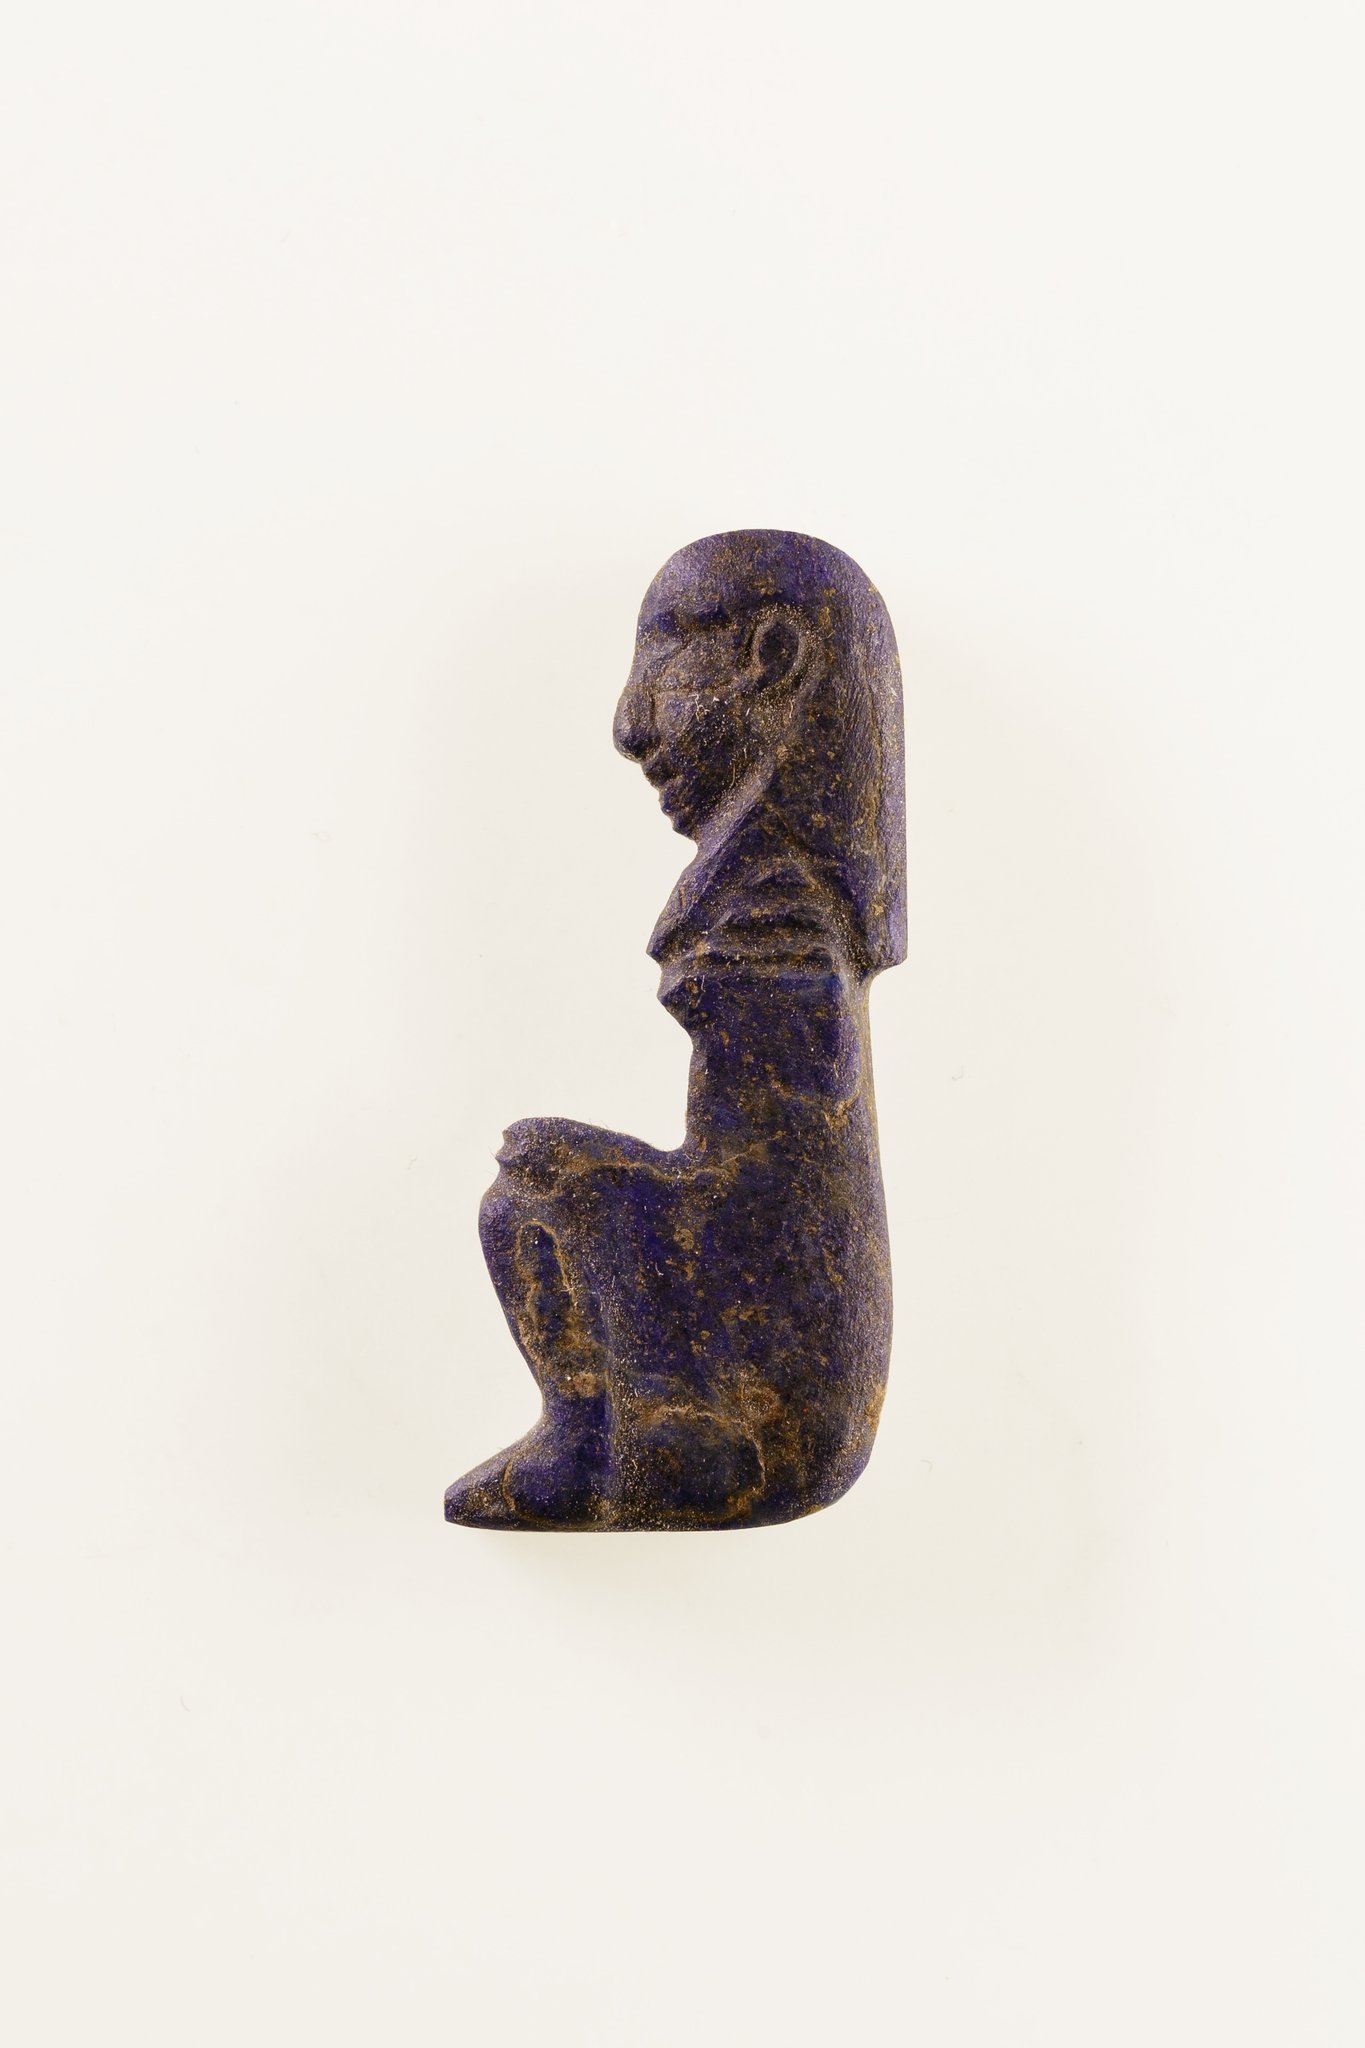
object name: inlay, hieroglyph, seated man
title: Seated man inlay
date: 522-343 BCE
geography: egypt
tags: men